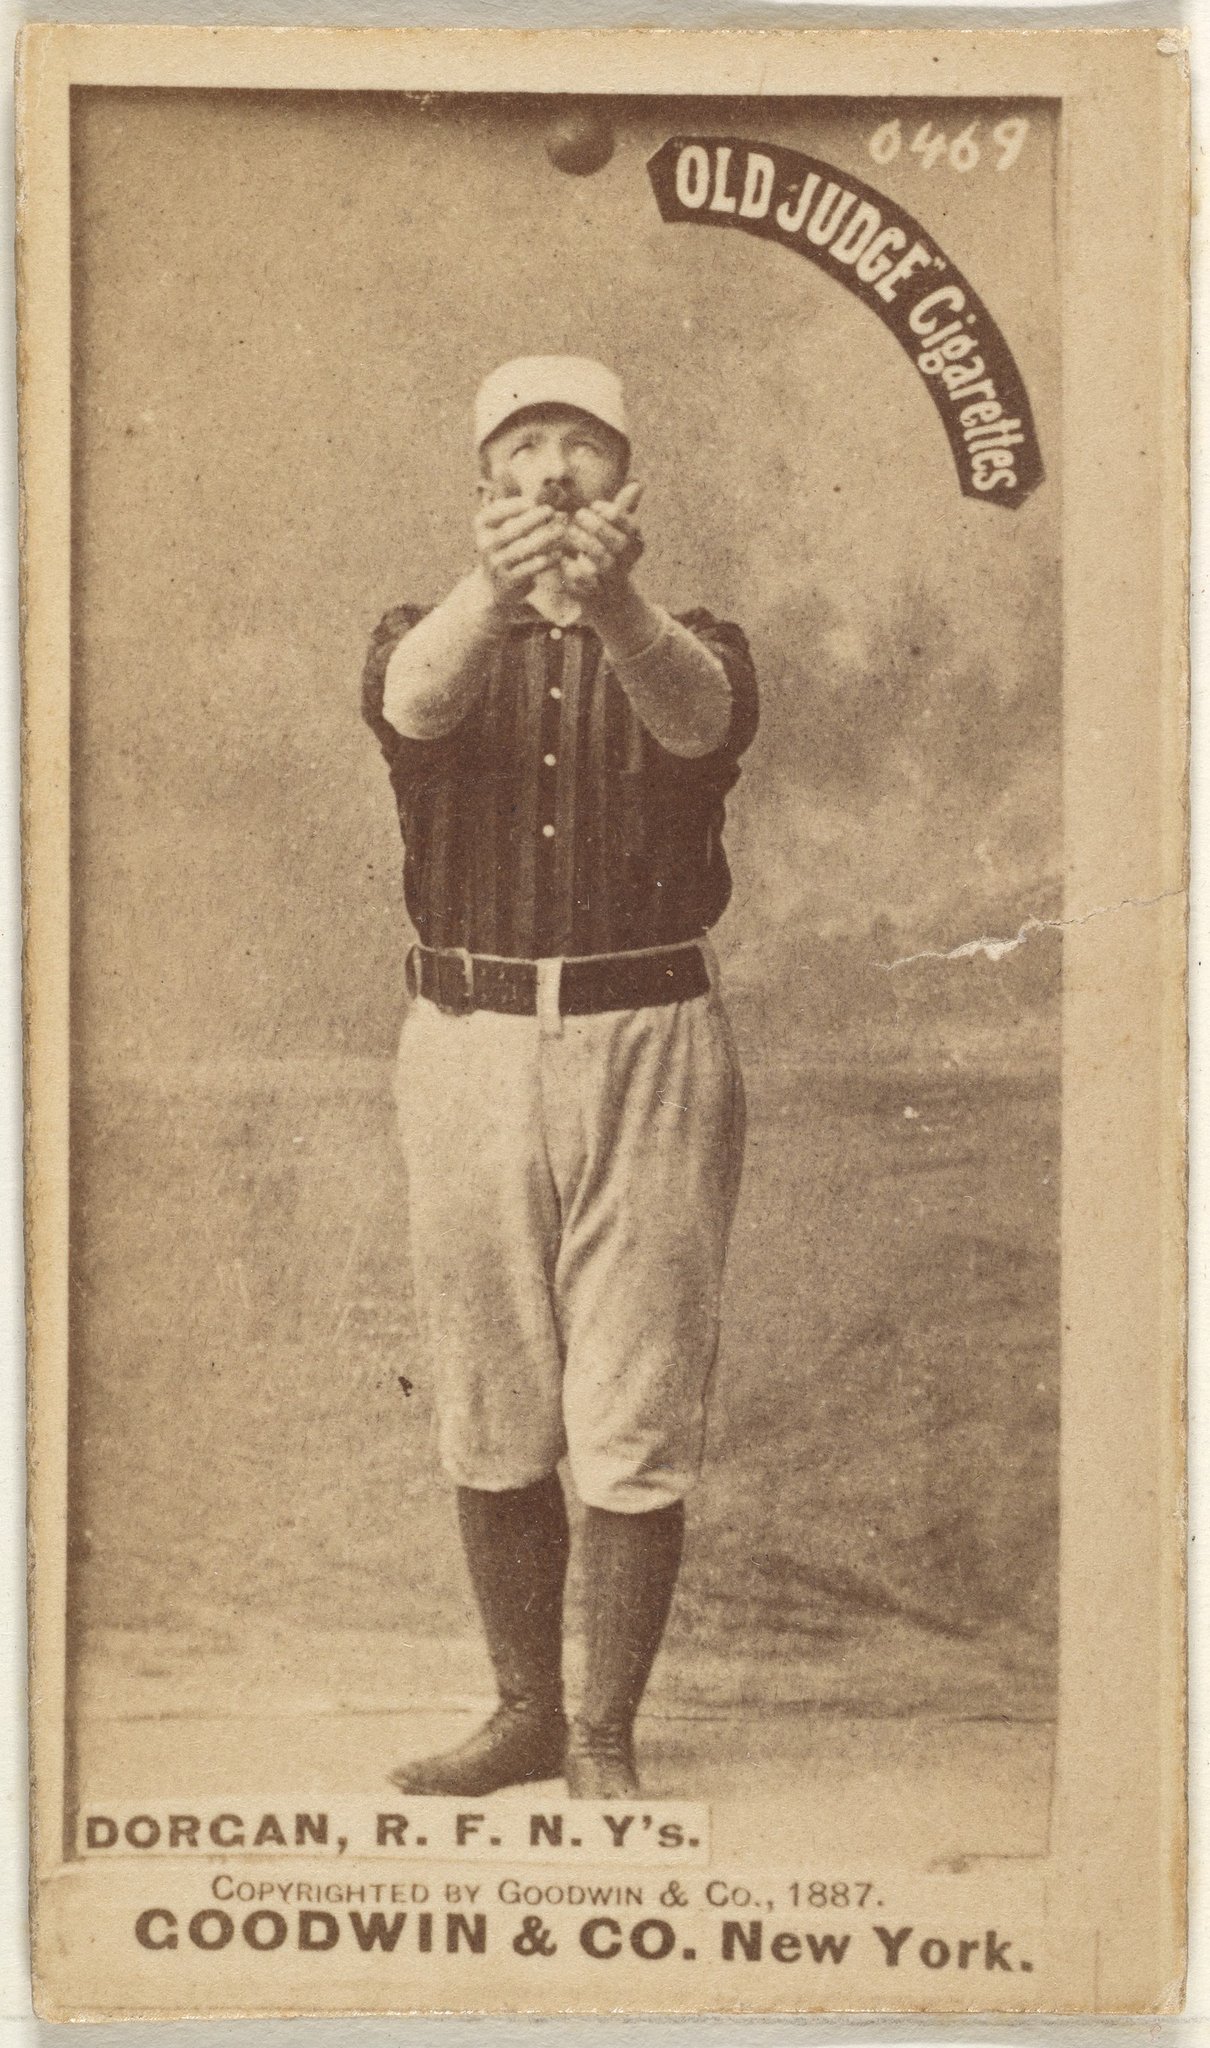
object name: baseball card, photograph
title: Michael Cornelius Dorgan, Right Field, New York, from the Old Judge series (N172) for Old Judge Cigarettes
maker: goodwin & company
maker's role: publisher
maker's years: 1850-1950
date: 1887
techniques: albumen silver print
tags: men,portraits,baseball,athletes